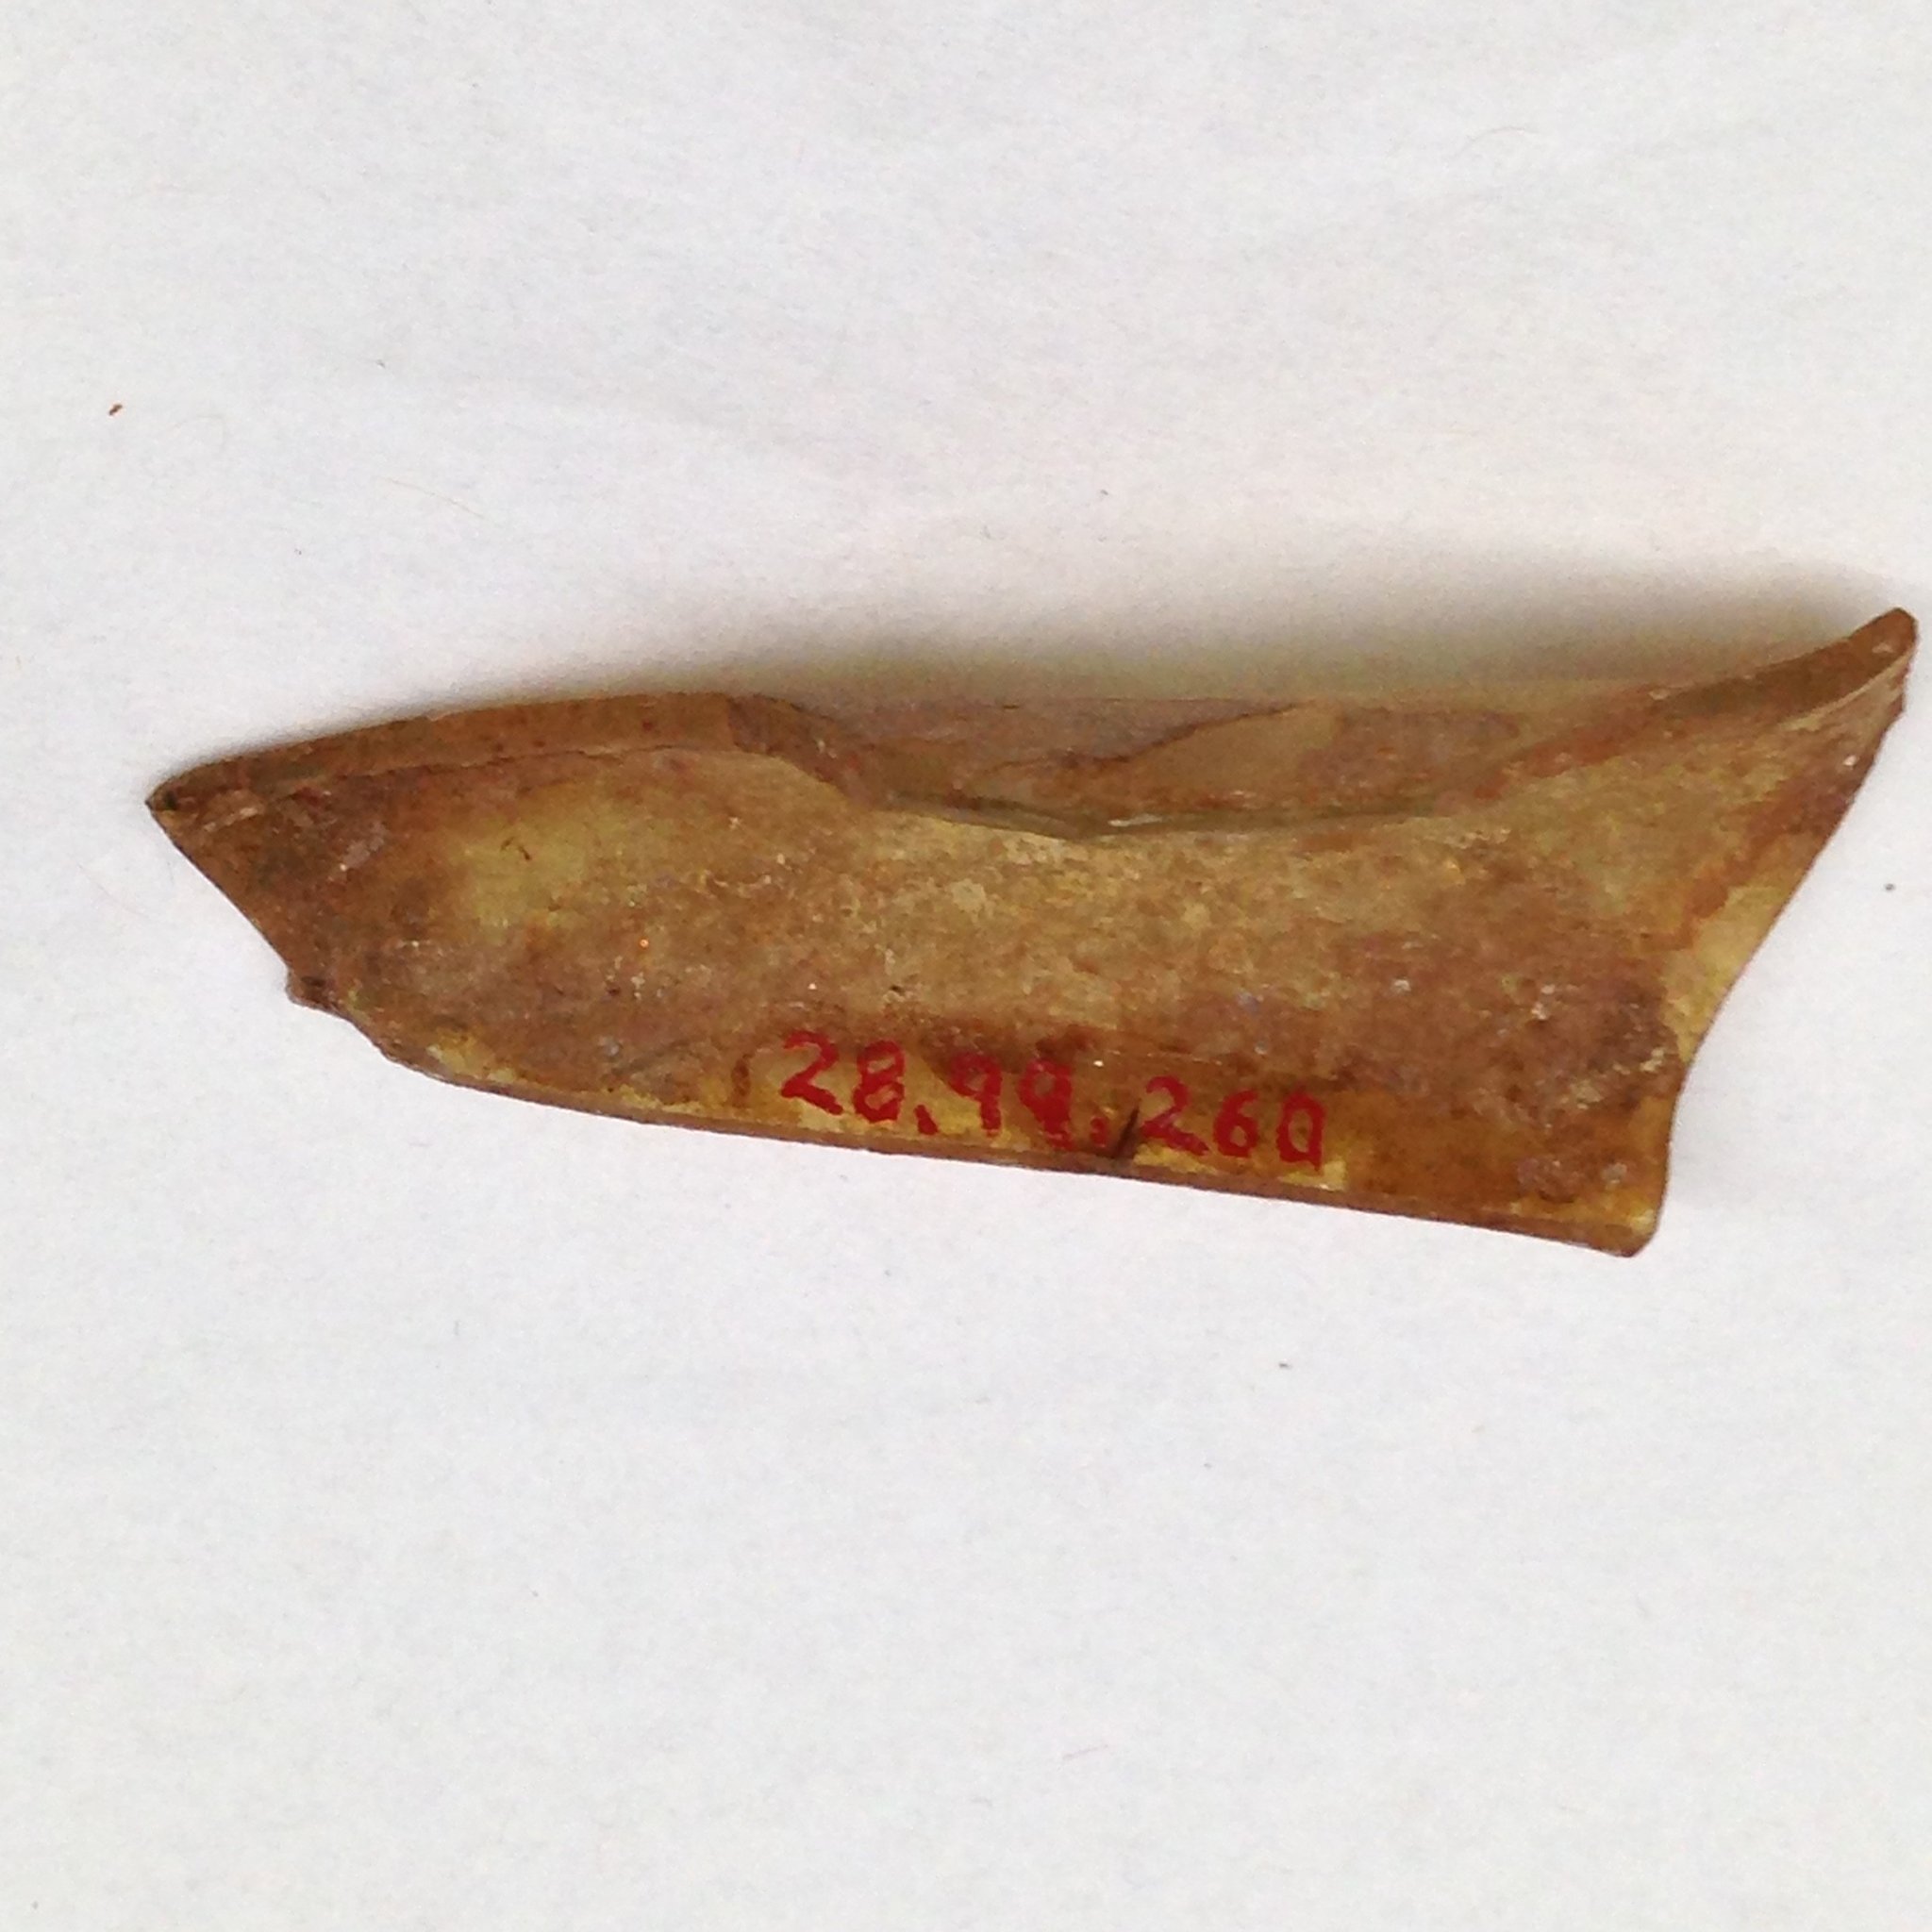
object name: fragment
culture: european or middle eastern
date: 1150-1250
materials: ceramic, glass